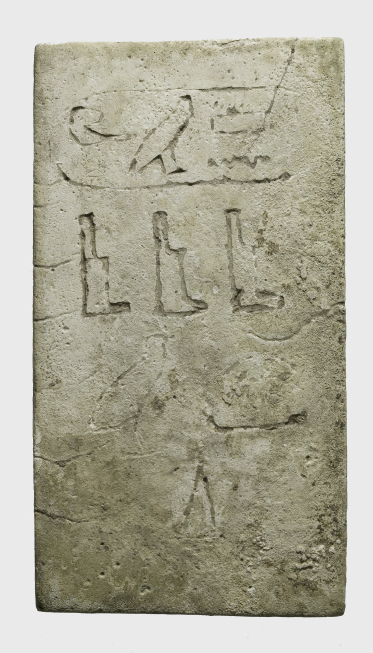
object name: foundation deposit plaque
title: Foundation deposit plaque of Amenemhat I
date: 1981-1952 BCE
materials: faience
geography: egypt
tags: hieroglyphs